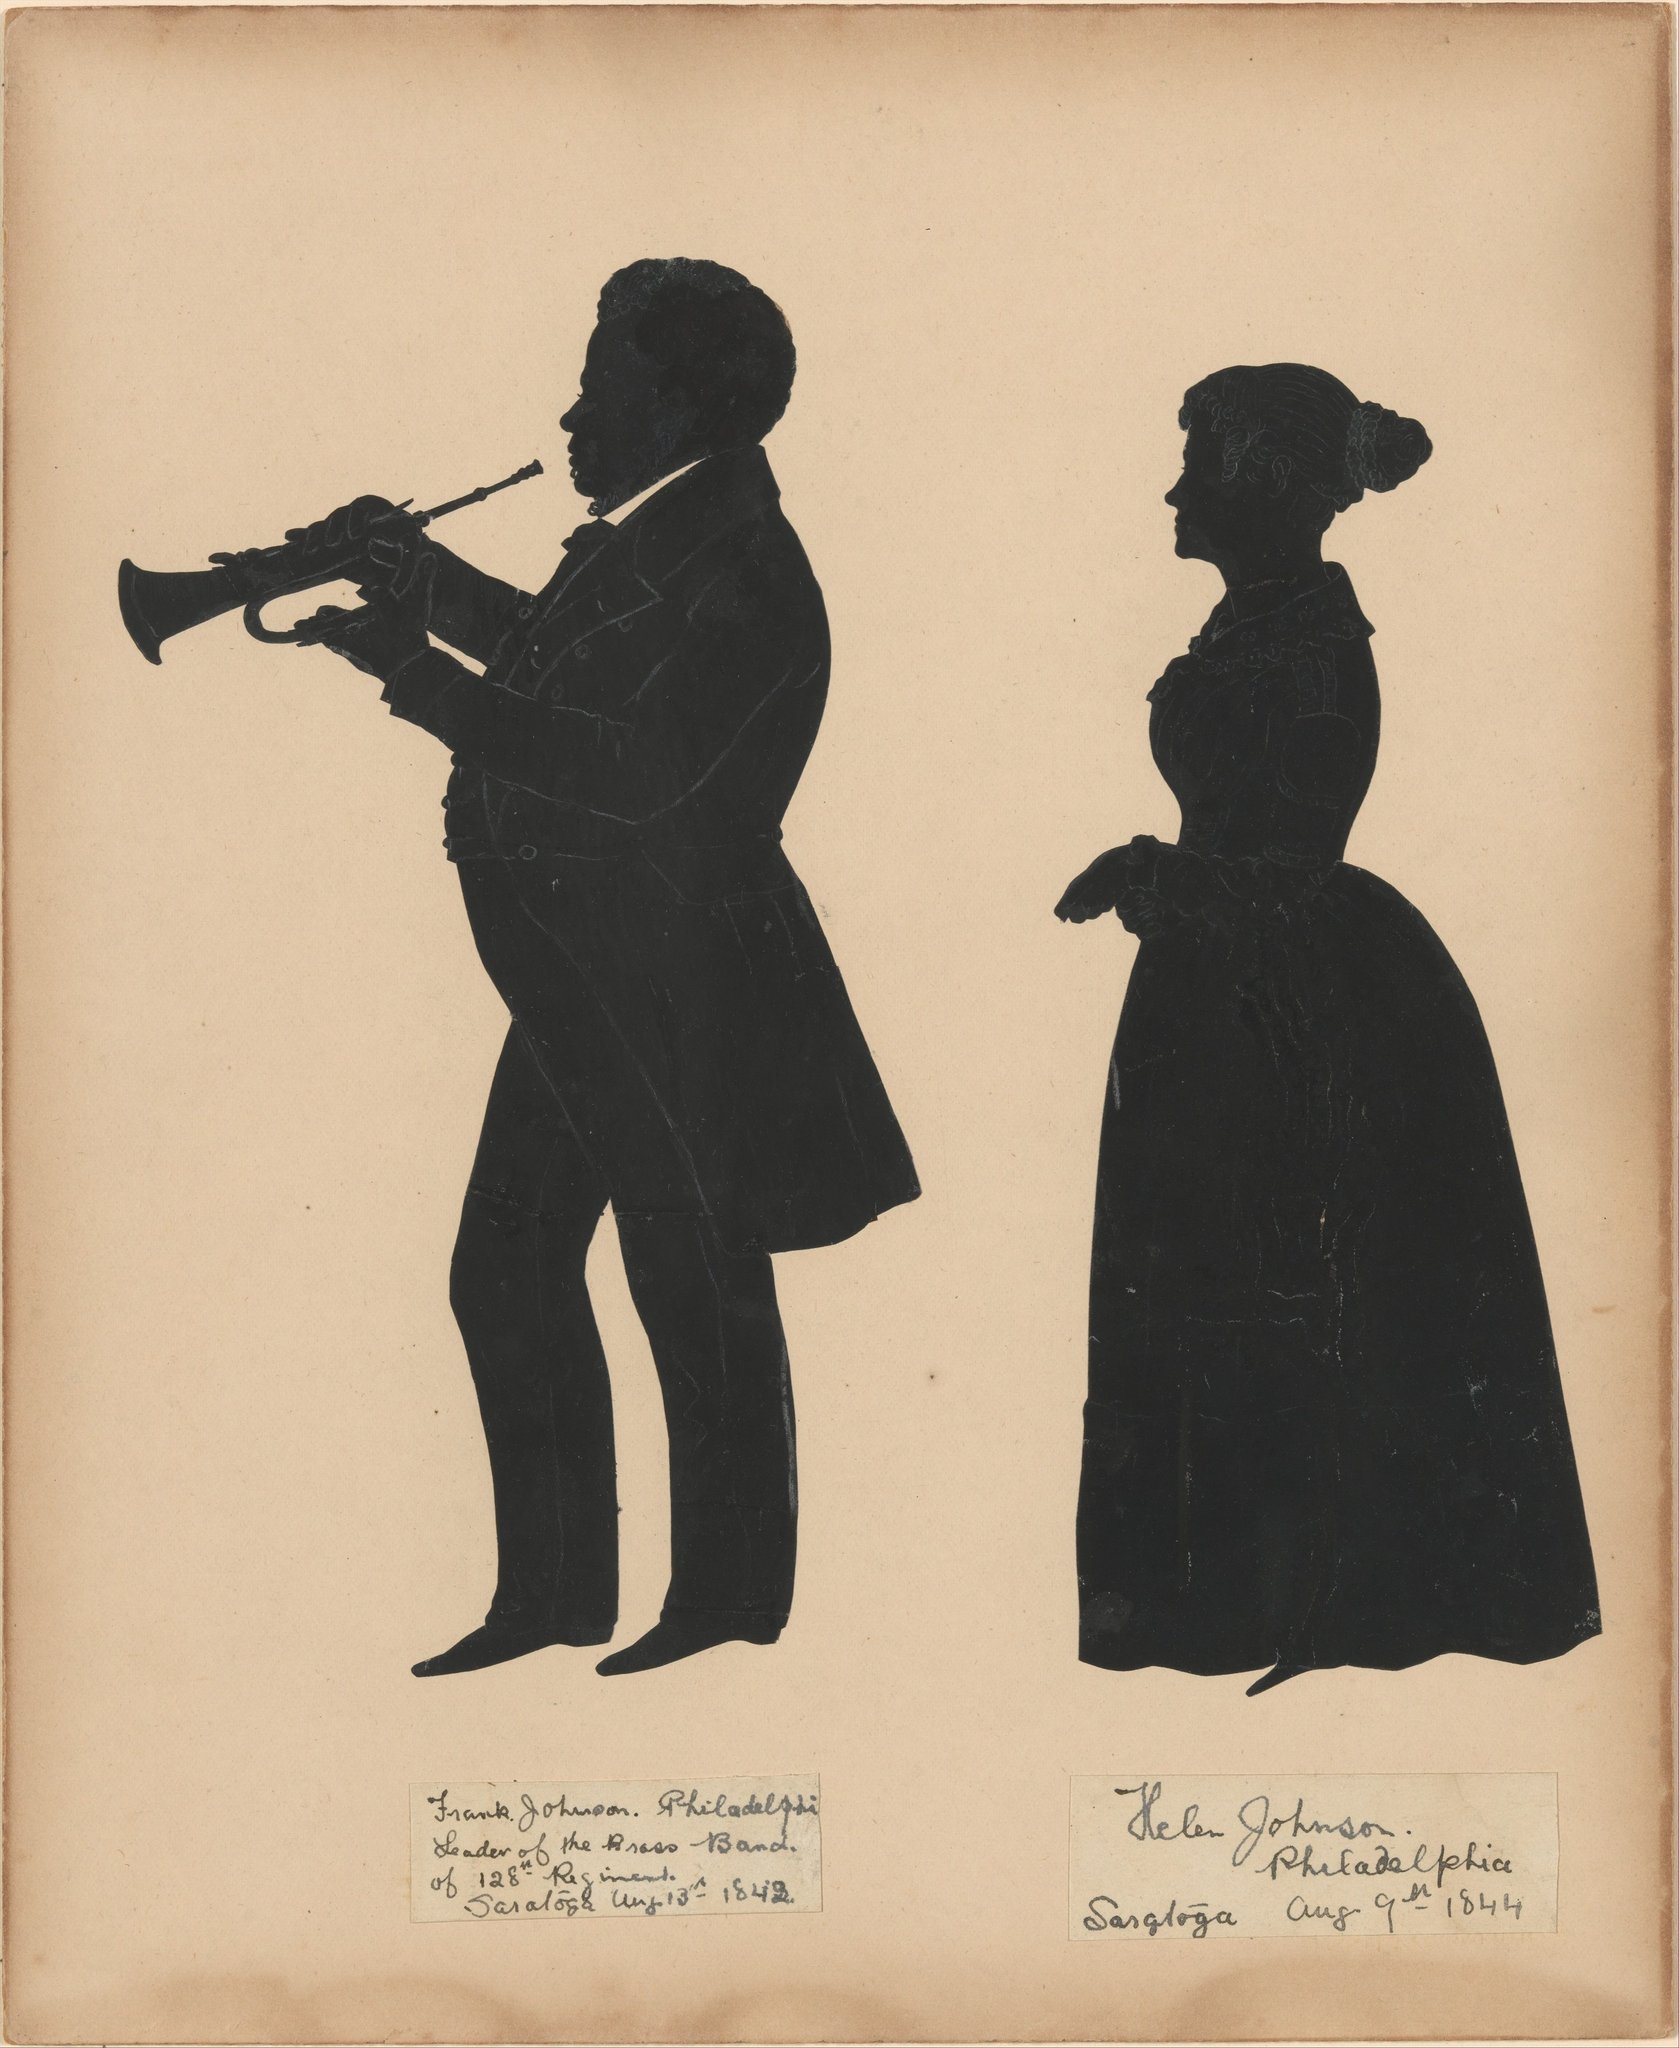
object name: cut paper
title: Frank Johnson, Leader of the Brass Band of the 128th Regiment in Saratoga, with his wife, Helen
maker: auguste edouart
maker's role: artist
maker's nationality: french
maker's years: 1789-1861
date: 1842-1844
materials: board, paper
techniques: cutting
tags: men,women,trumpets